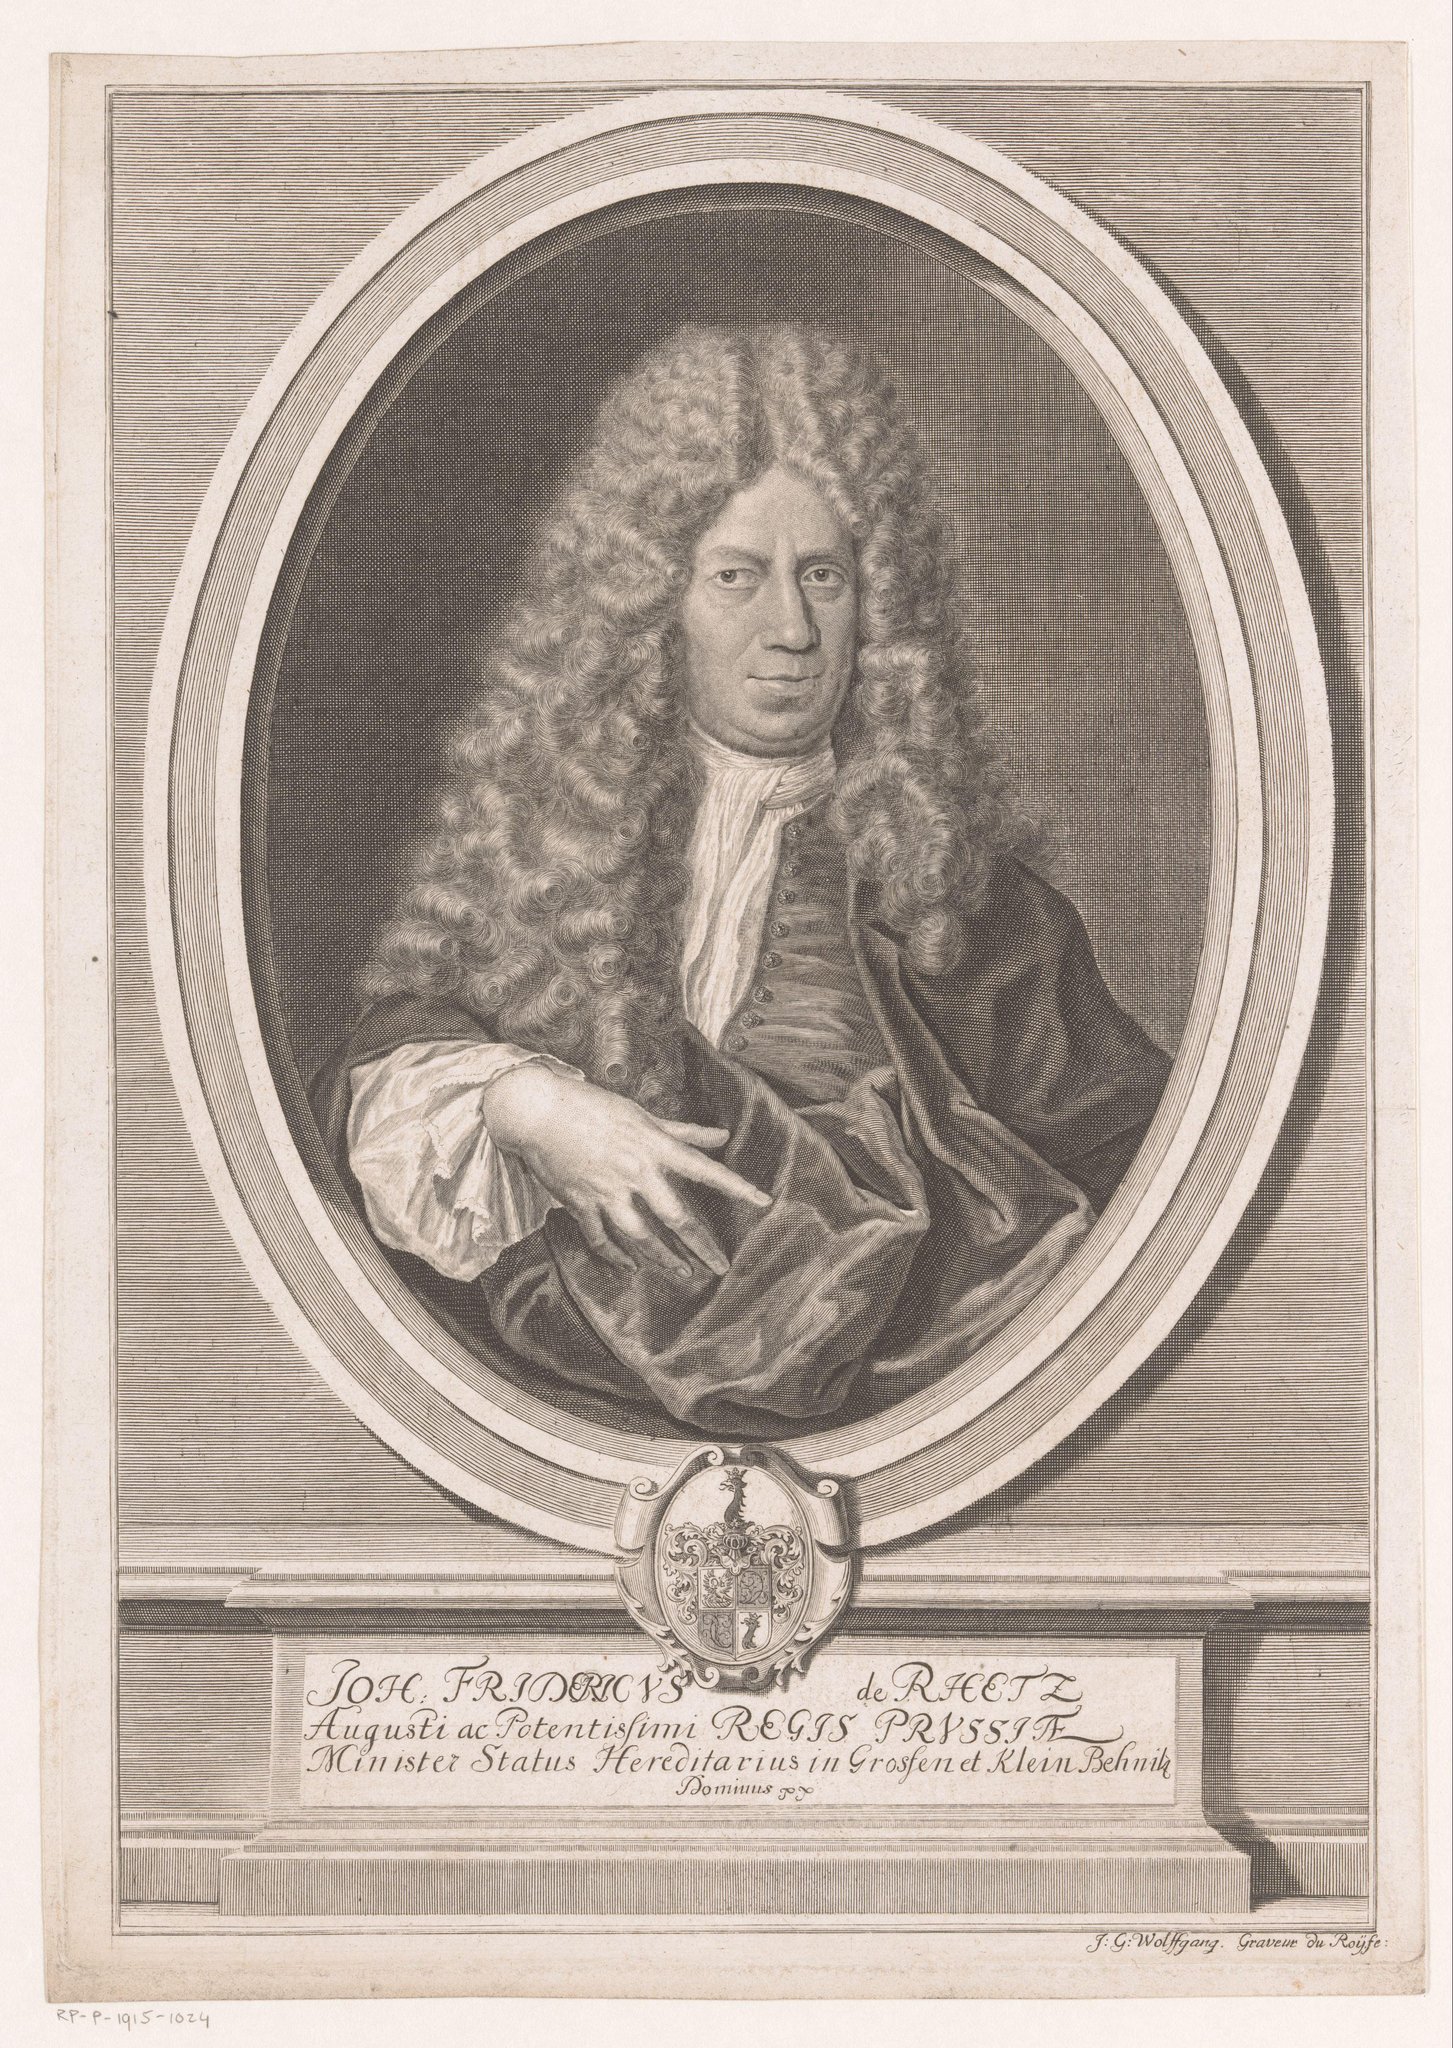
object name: print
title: Portret van Johann Rhetz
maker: johann georg wolfgang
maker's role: graveur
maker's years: 1662-1744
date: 1672-1744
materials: paper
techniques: engraving, etching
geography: germany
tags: berlin, johann friedrich rhetz, historical persons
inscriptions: collector's mark: Lugt 2228